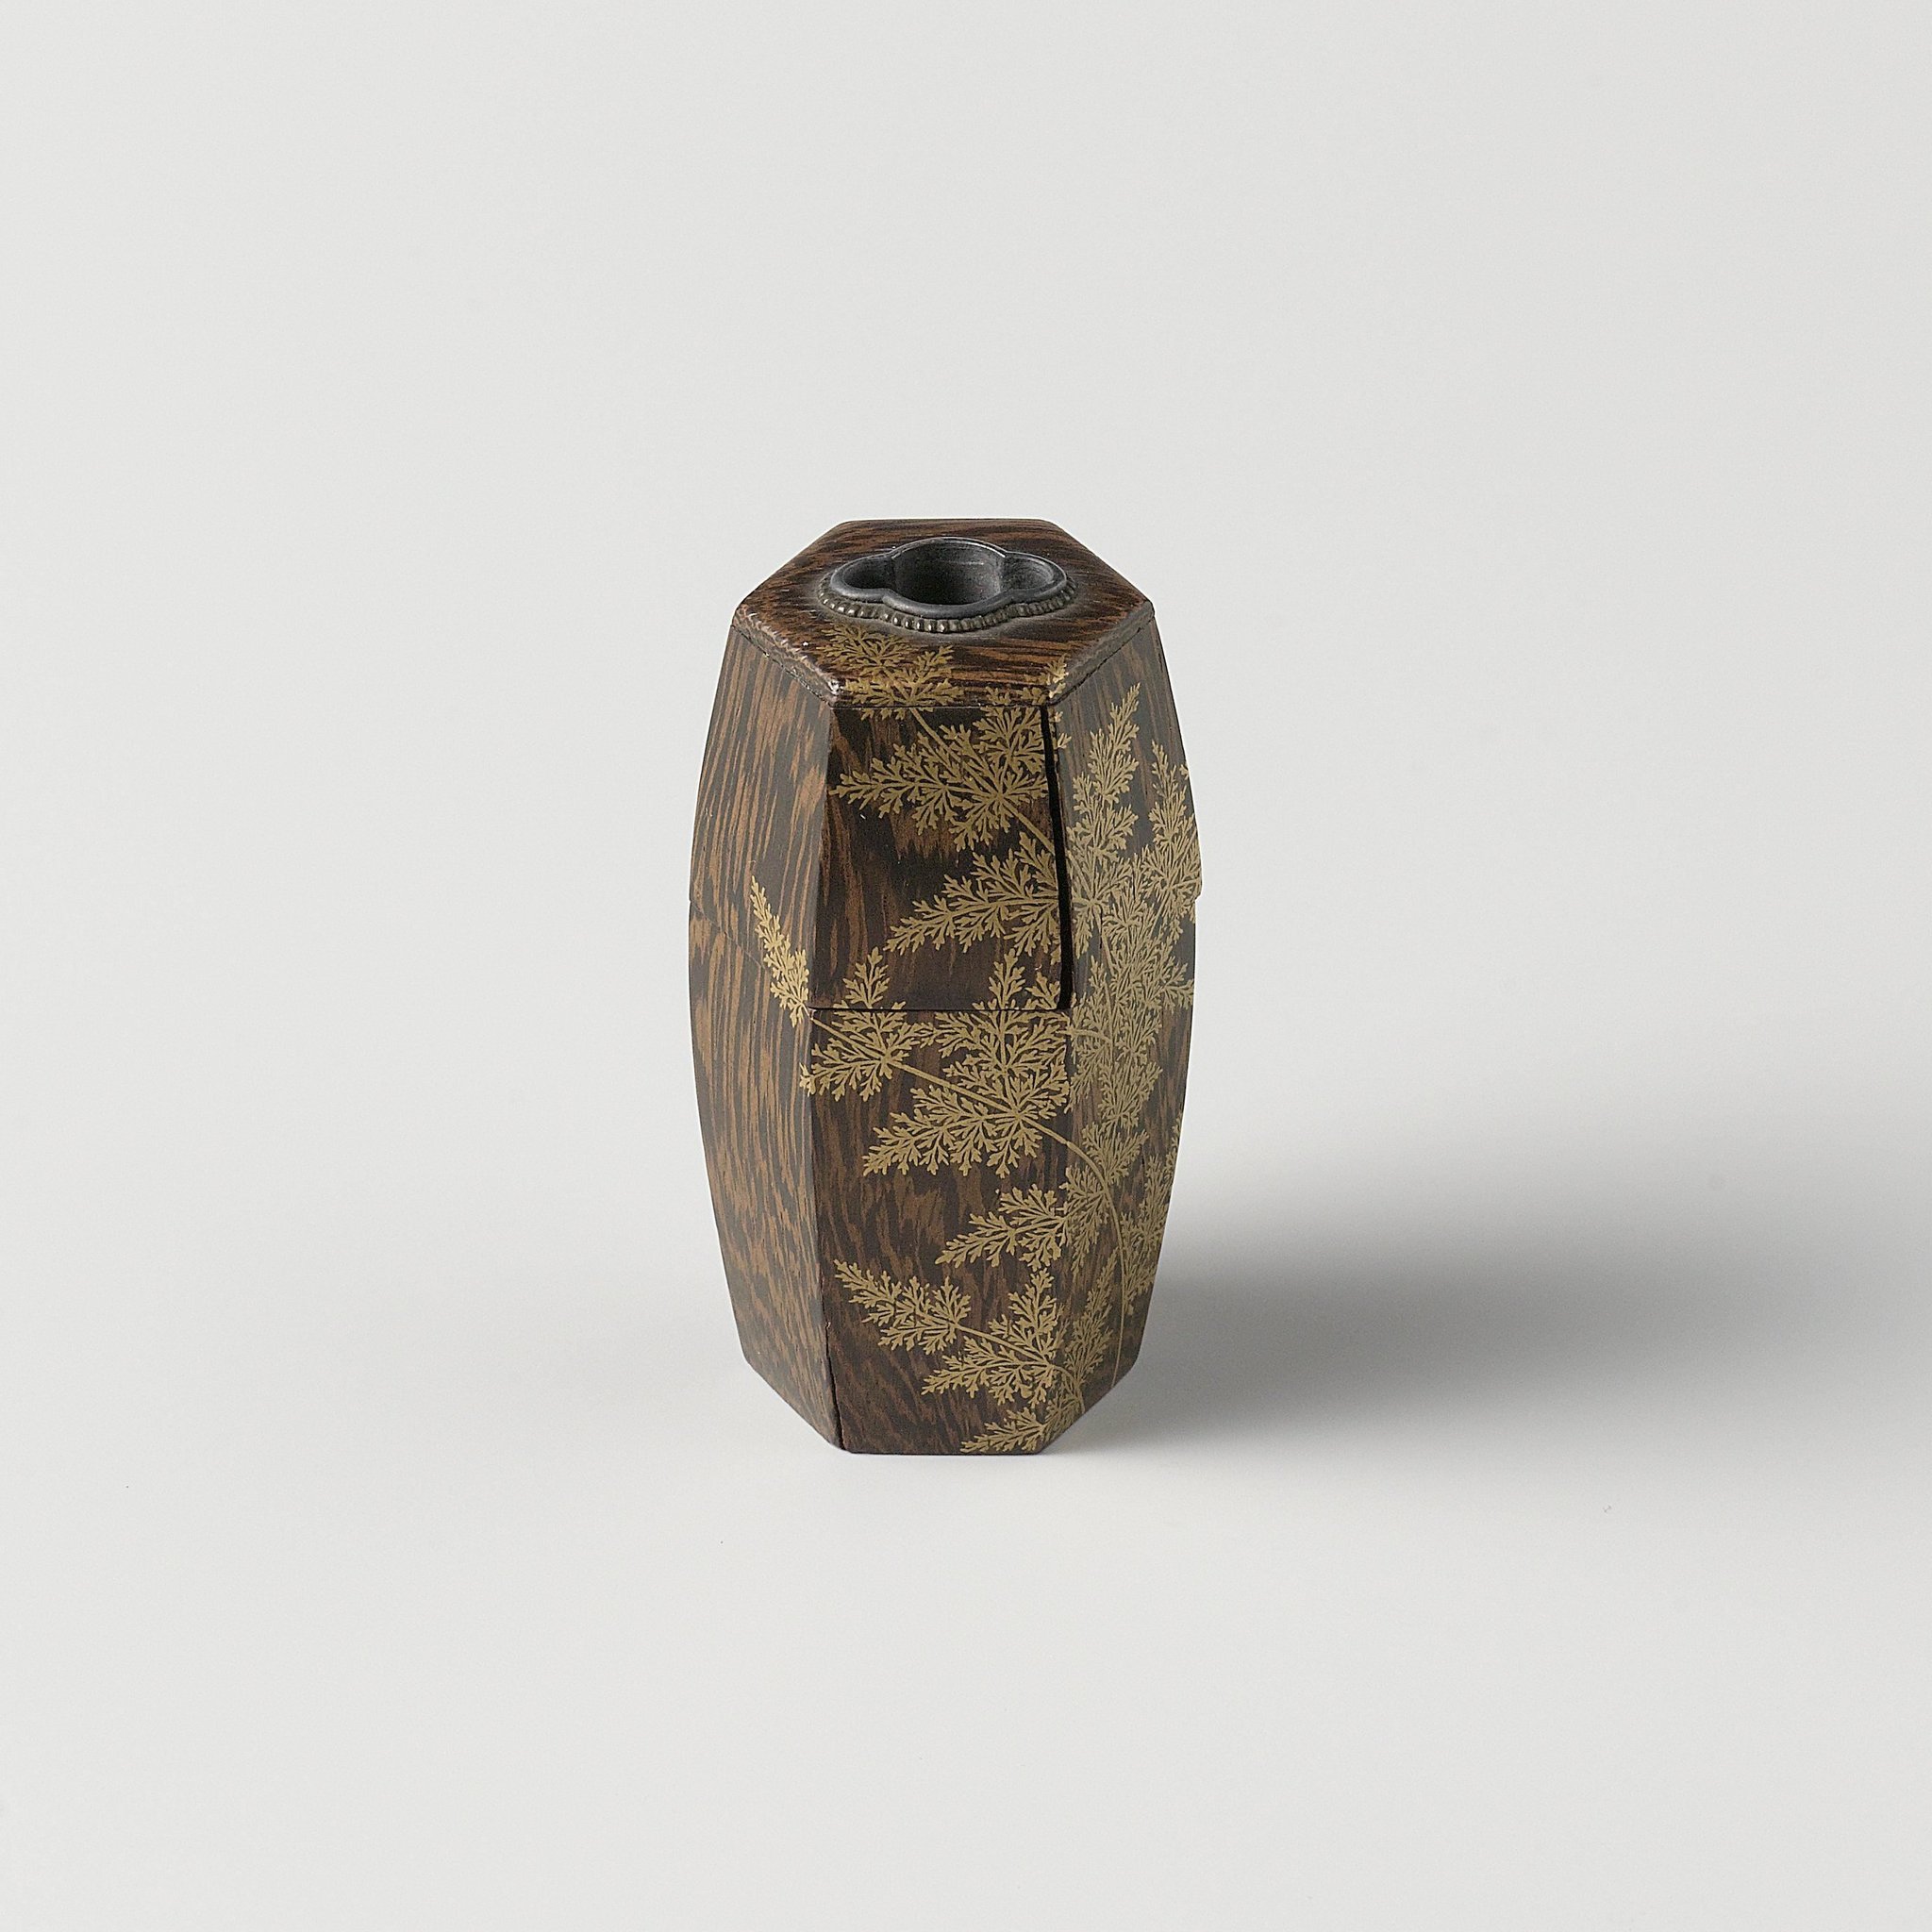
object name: box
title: Doos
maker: Anonymous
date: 1750-1800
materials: lacquer, wood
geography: japan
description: Achthoekig langwerpig doosje met zowel boven als onder afgeplatte kanten.